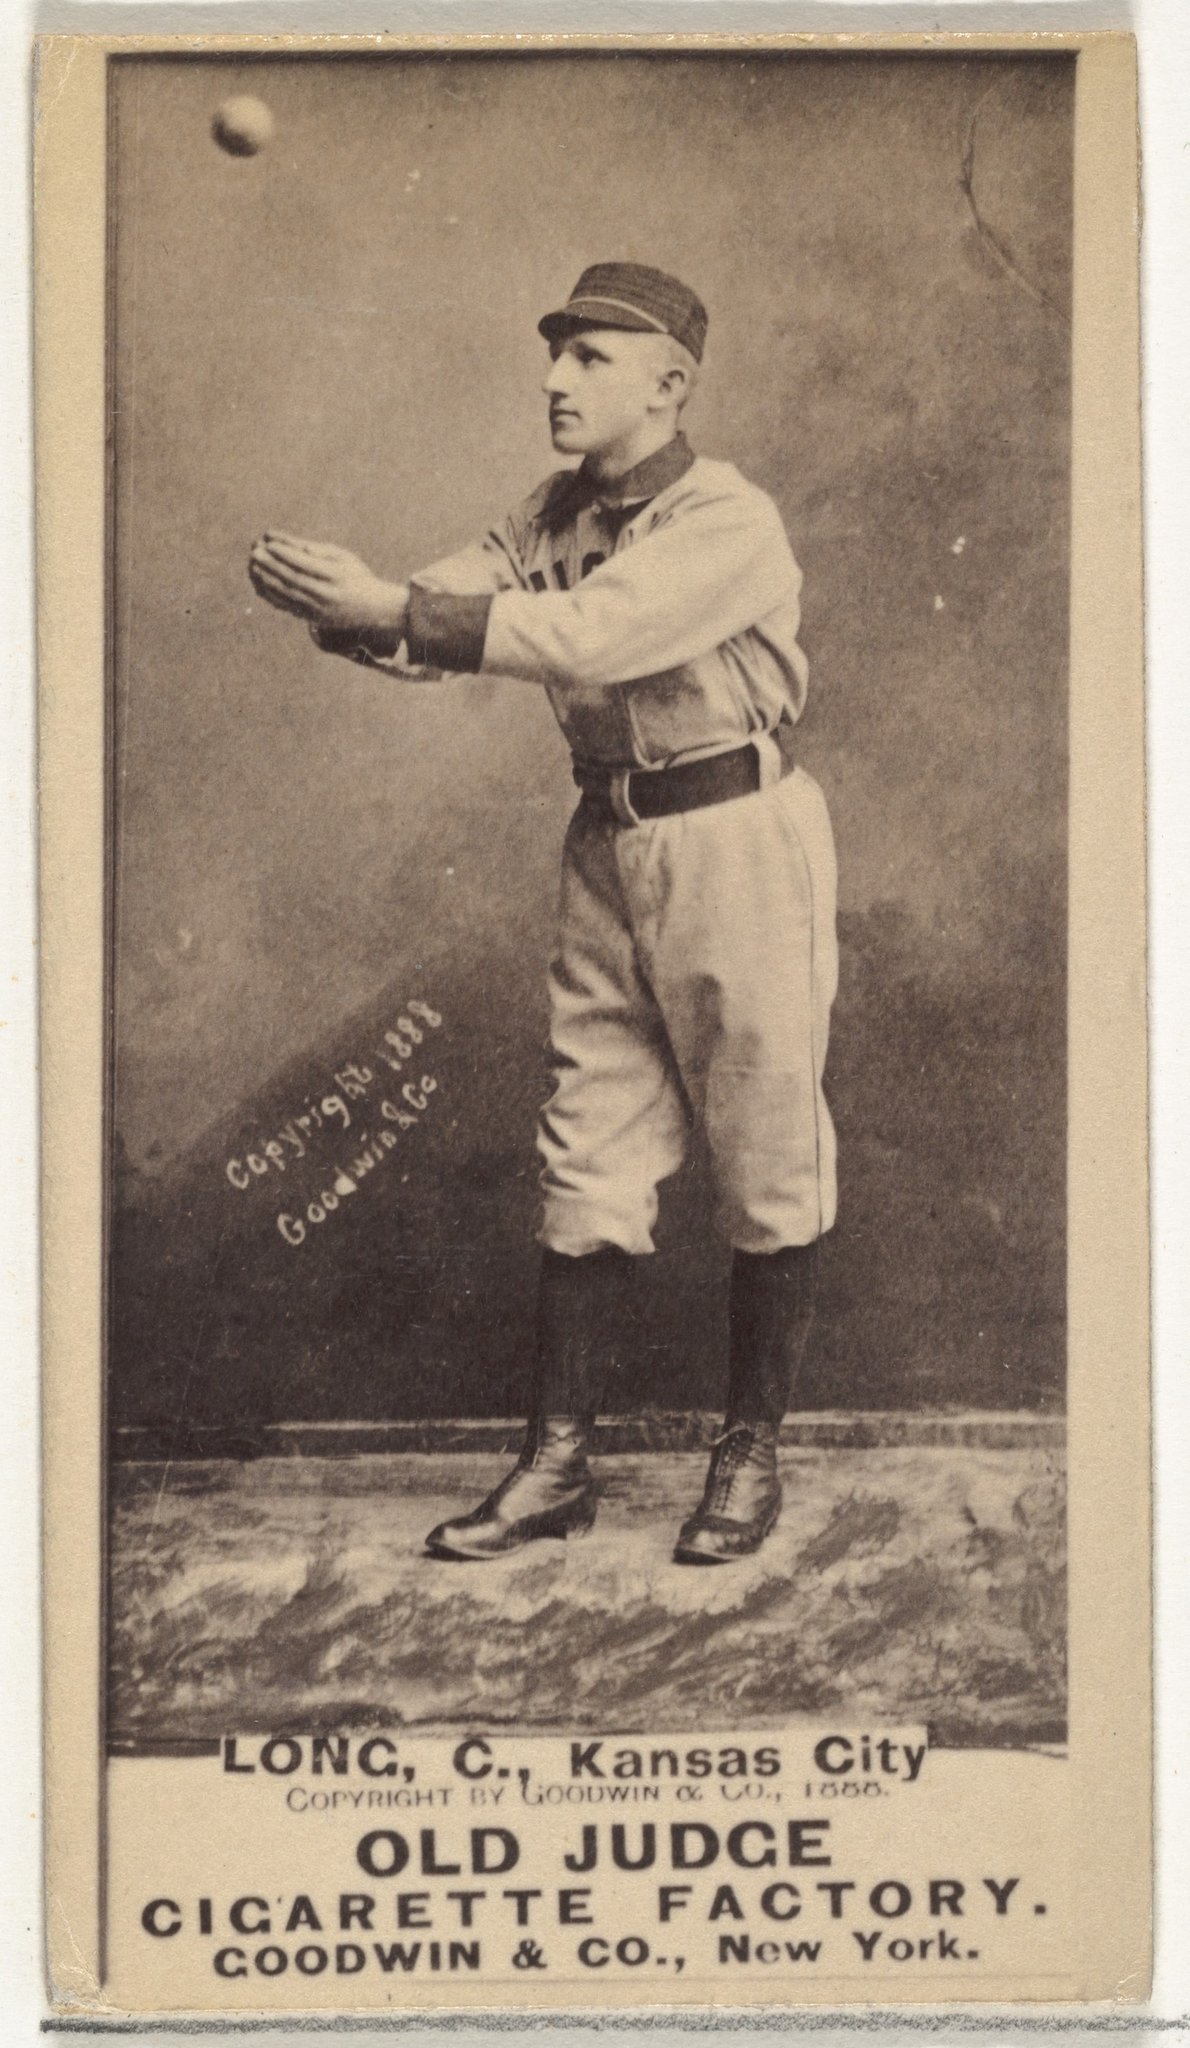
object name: baseball card, photograph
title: Herman C. Long, Catcher, Kansas City Cowboys, from the Old Judge series (N172) for Old Judge Cigarettes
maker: goodwin & company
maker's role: publisher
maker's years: 1850-1950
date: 1888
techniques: albumen silver print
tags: men,portraits,baseball,athletes